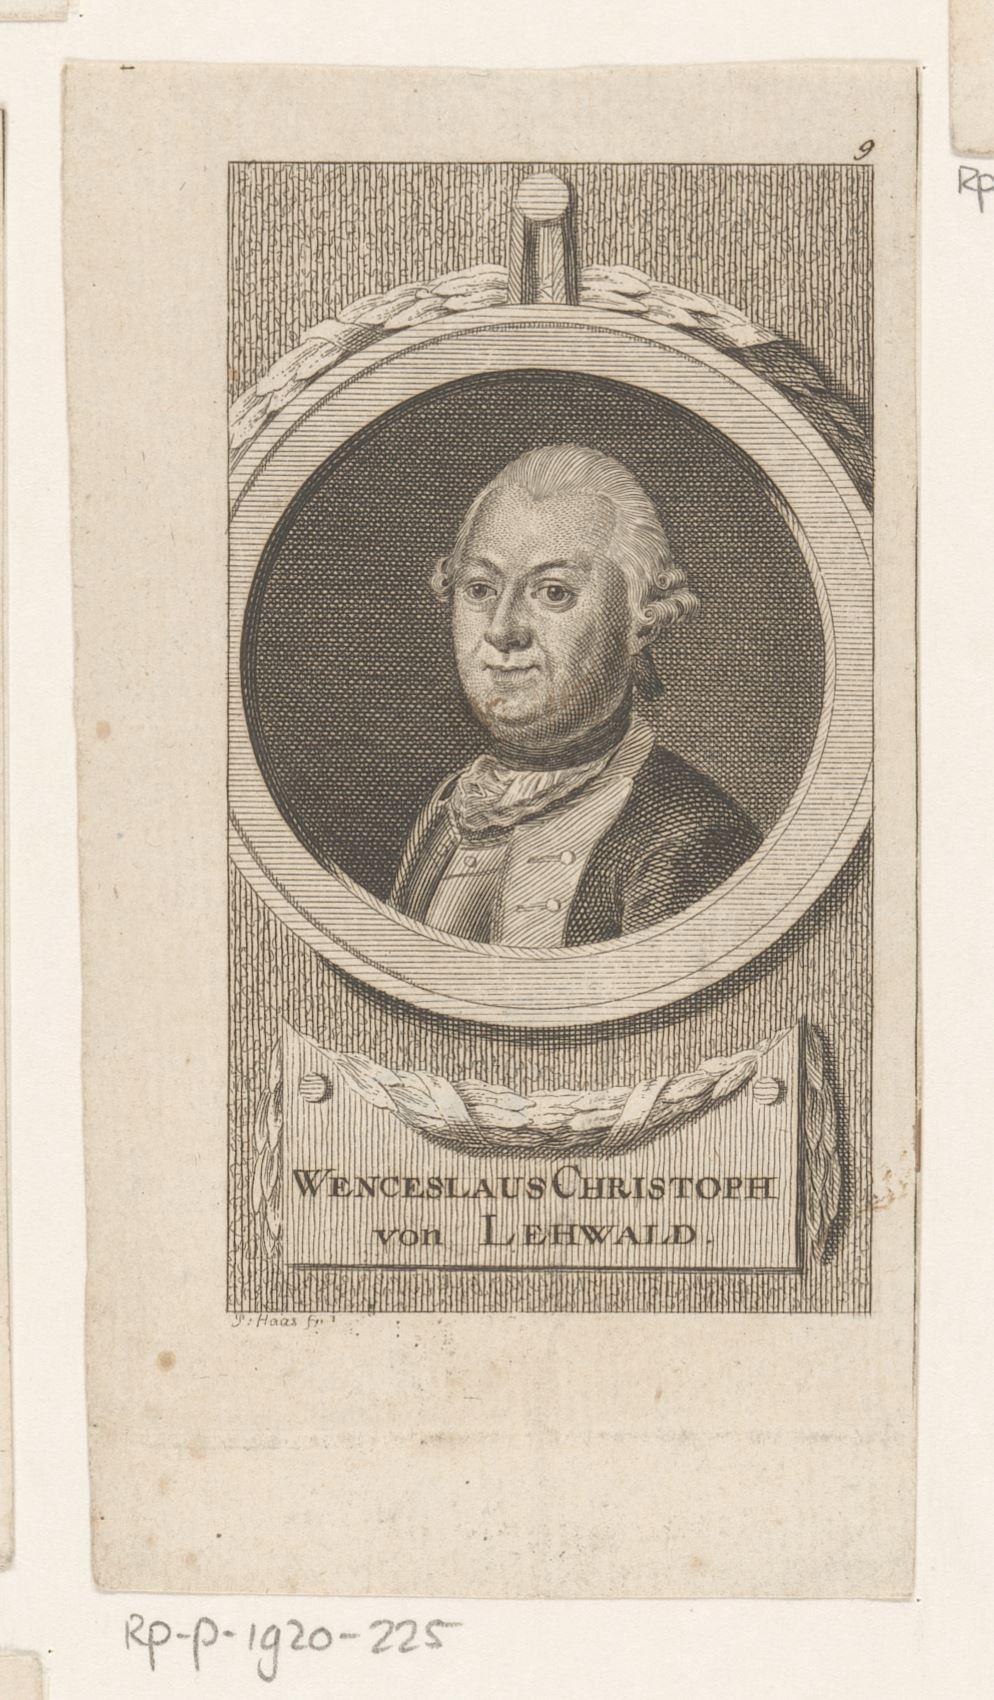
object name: print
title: Portret van Wenzeslaus Christoph von Lehwald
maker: peter haas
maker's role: print maker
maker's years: 1754-1804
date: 1764-1804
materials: paper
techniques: engraving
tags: ornament ~ medallion, commander-in-chief, general, marshal, historical persons, ornament ~ festoon, garland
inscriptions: collector's mark: Lugt 2228